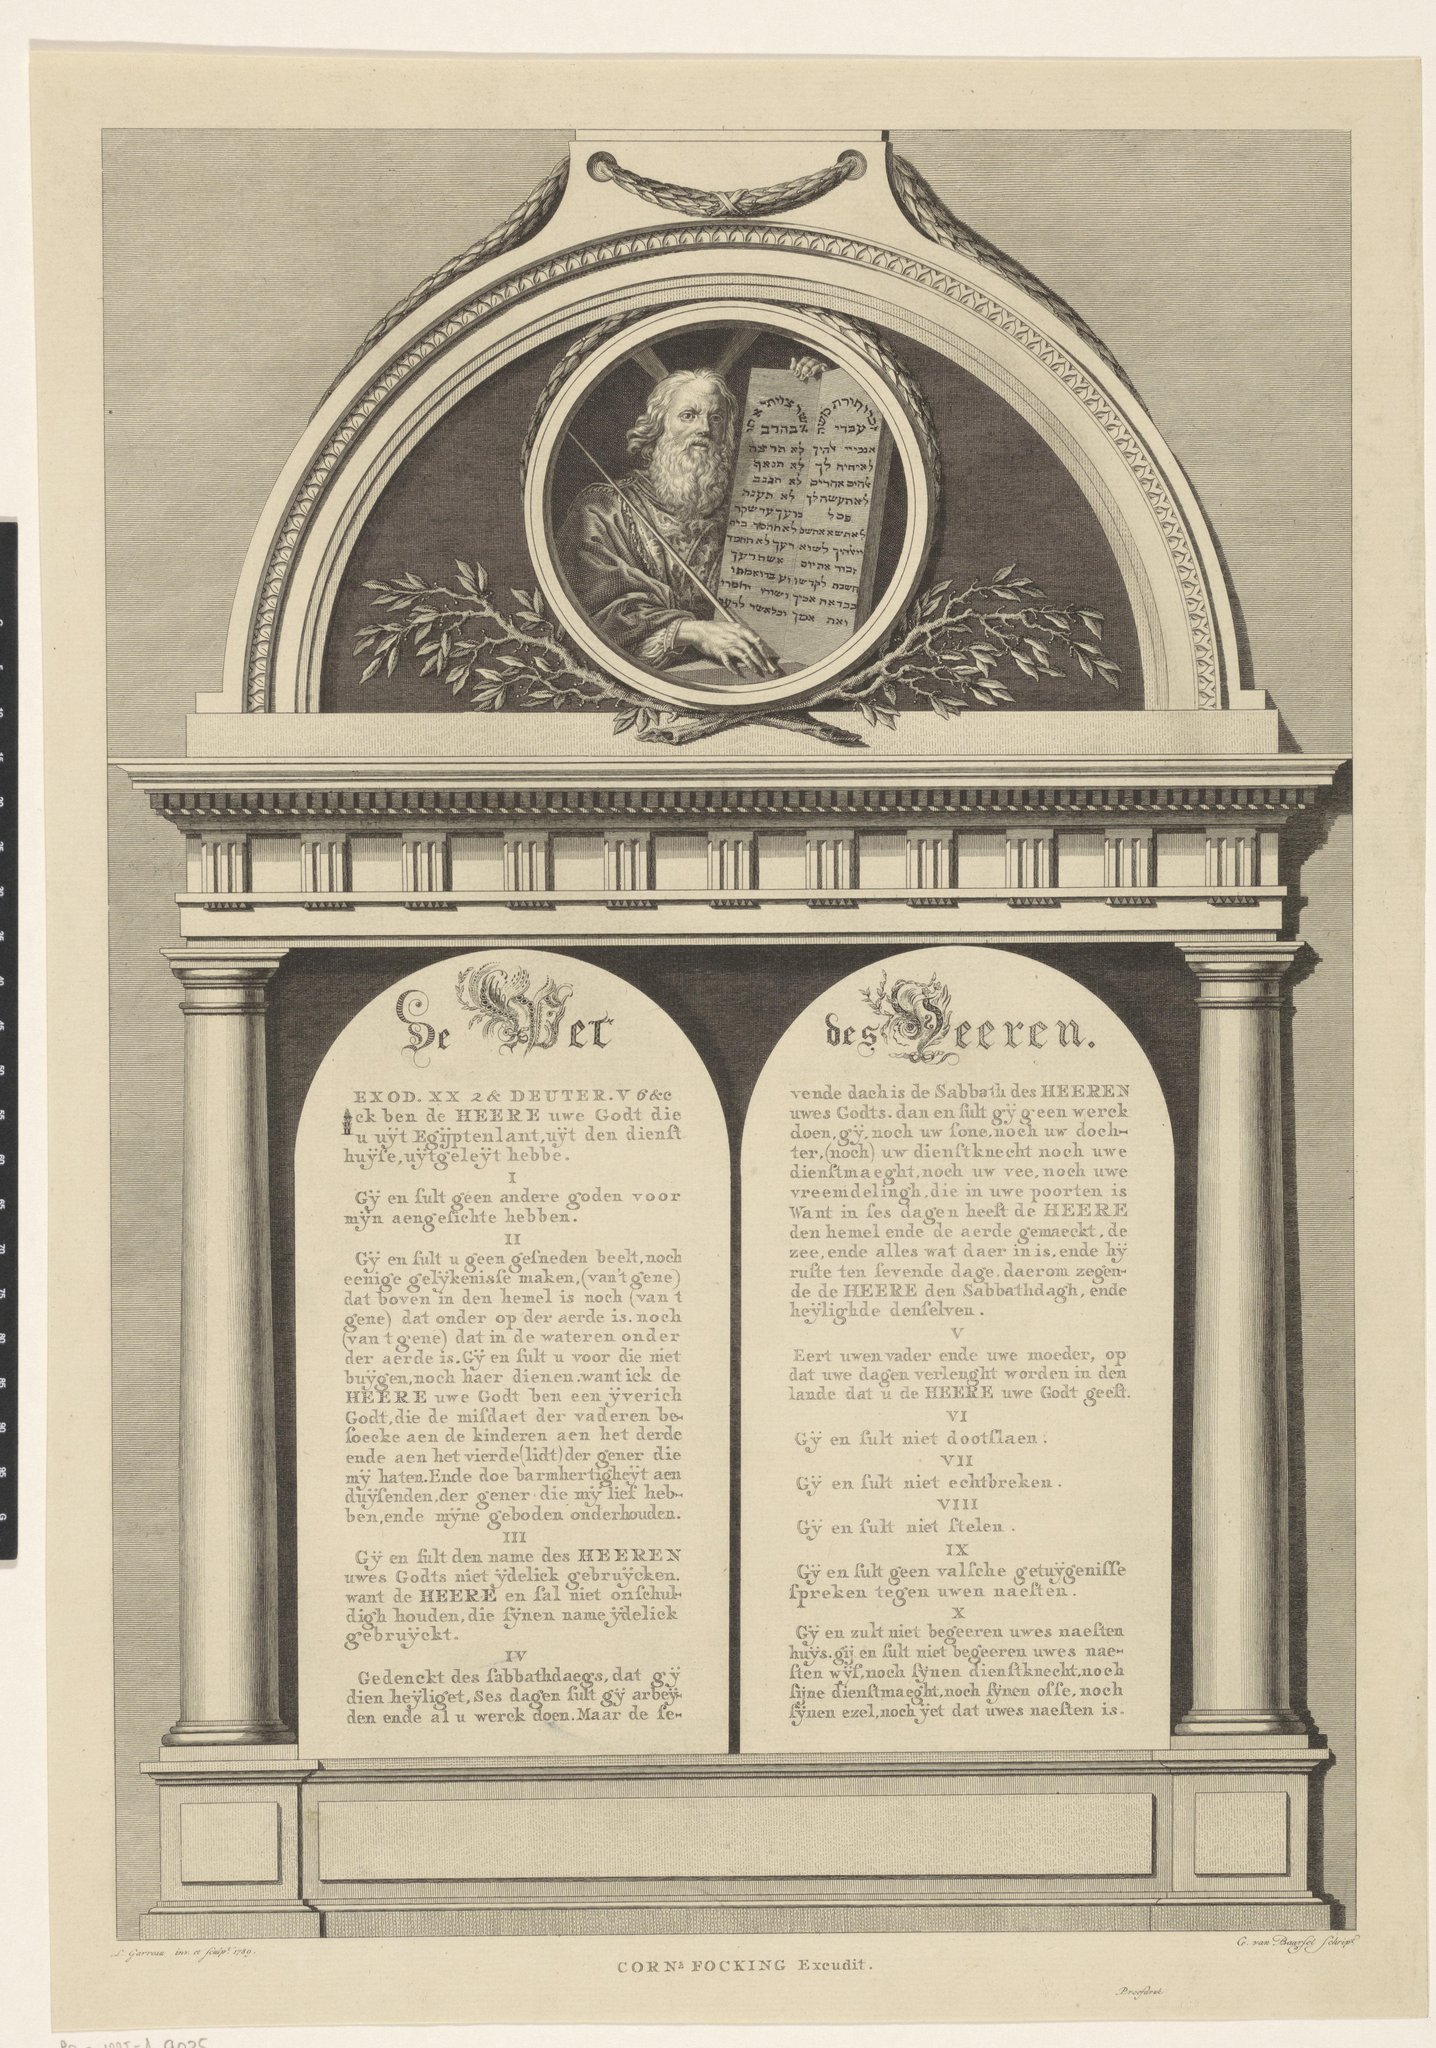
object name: print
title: Mozes en de tien geboden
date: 1789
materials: paper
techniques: engraving, etching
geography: amsterdam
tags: the ten commandments (exodus 20:3-17), moses on mount sinai with the tables of the law (exodus 24:9-18, 31:18)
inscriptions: collector's mark: Lugt 2228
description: De twee stenen tafelen met de tien geboden in kalligrafie. Centraal bovenaan in een rond medaillon: Mozes met de tien geboden.